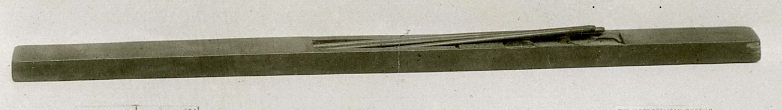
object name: palette, scribe's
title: Scribal palette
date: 306-30 BCE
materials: ink, wood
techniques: brush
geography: fayum